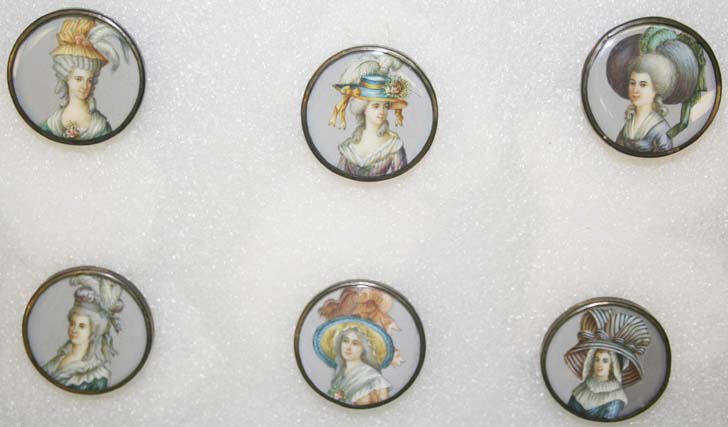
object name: button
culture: french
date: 1775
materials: ivory, metal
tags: portraits,women